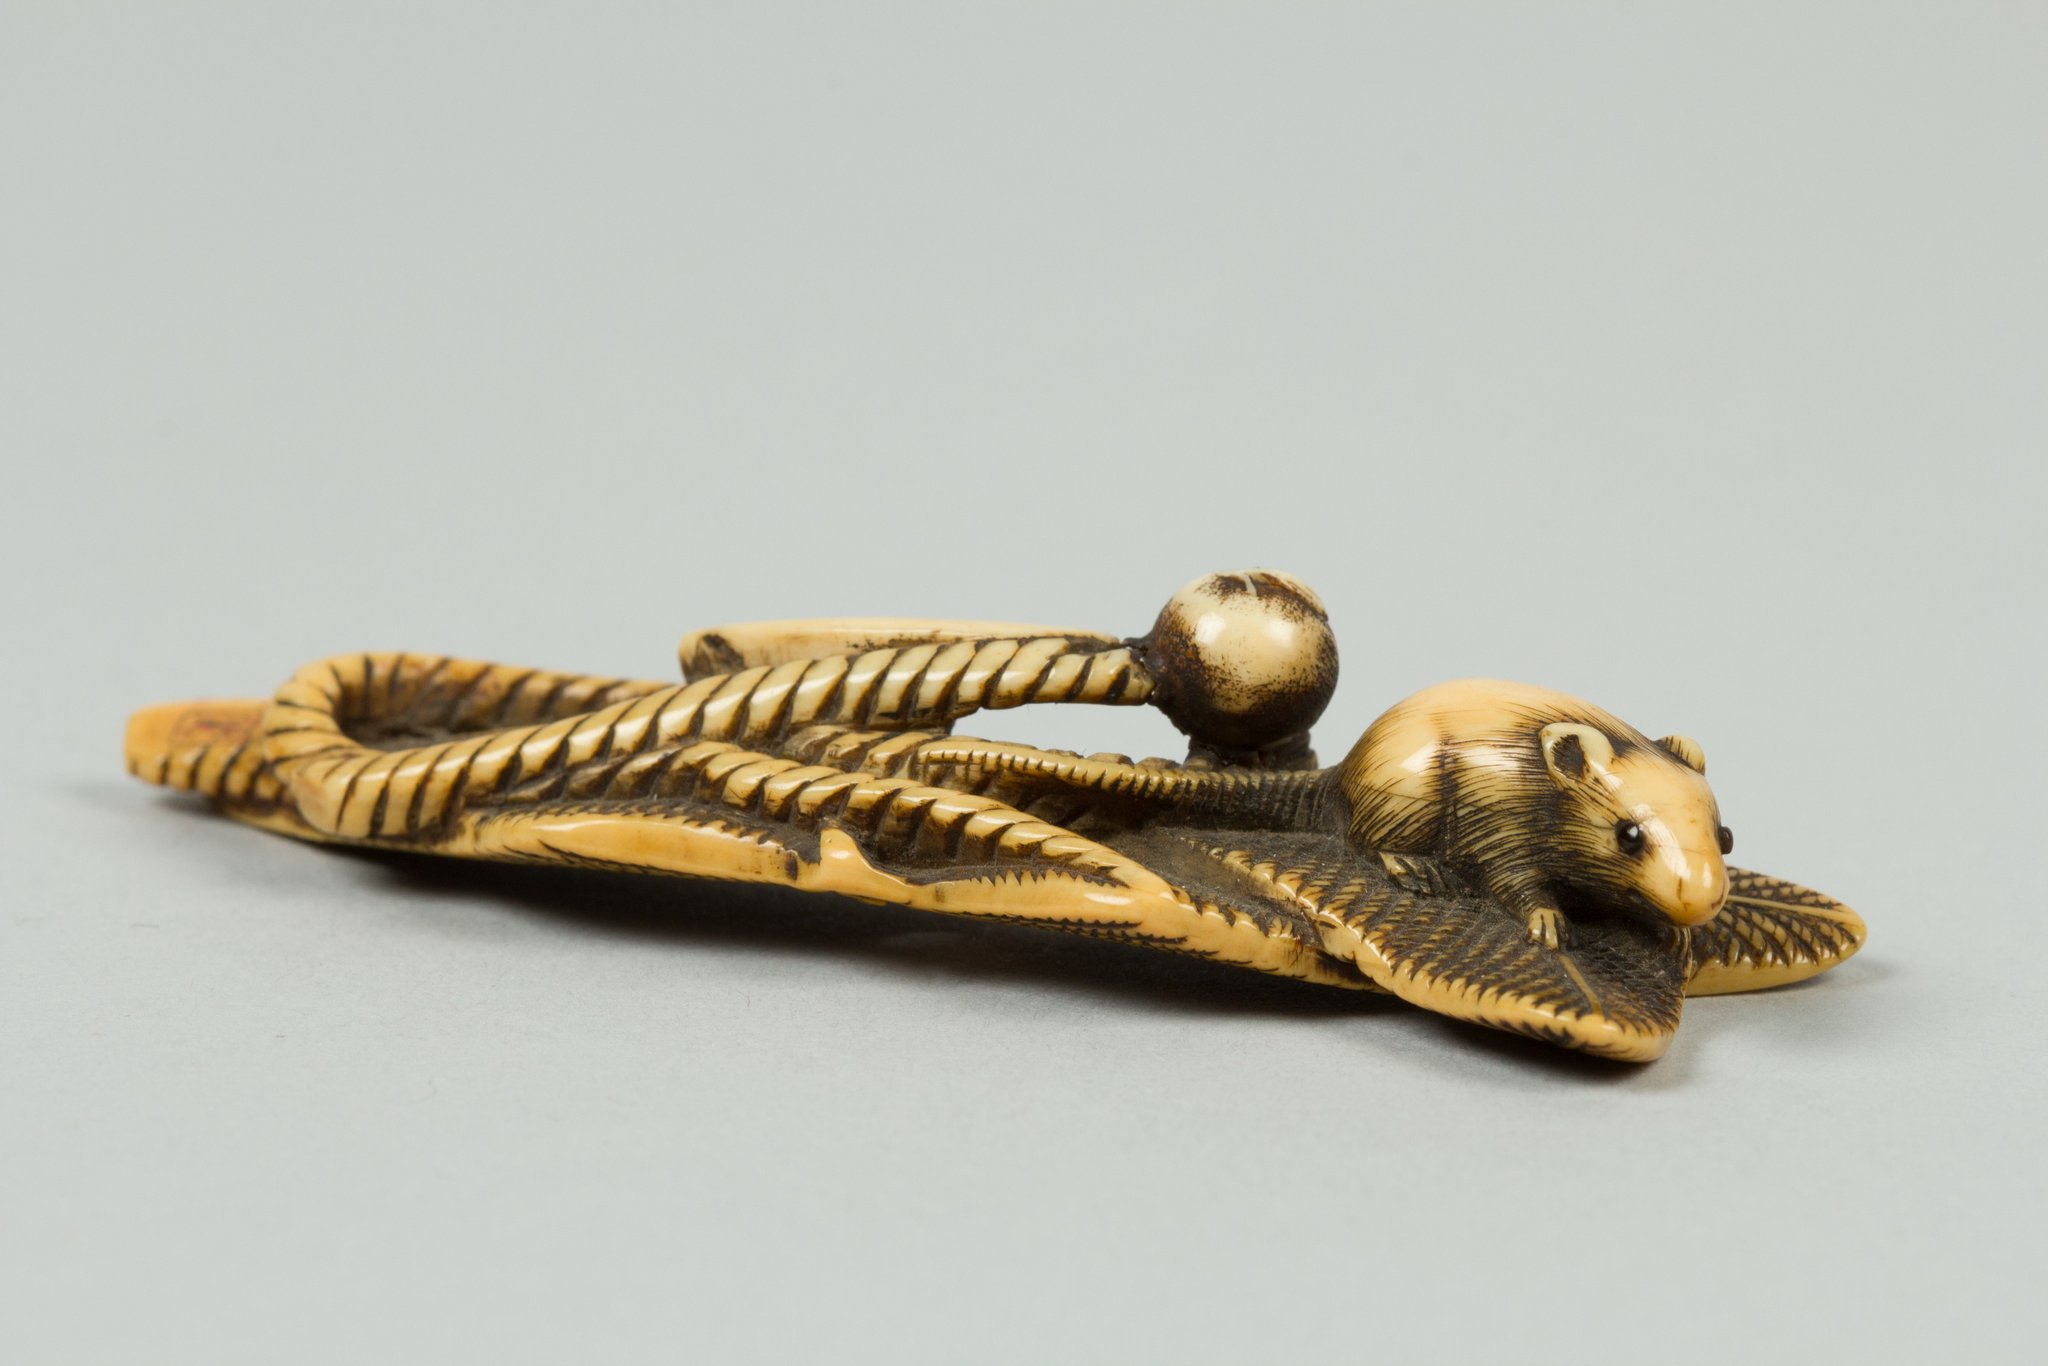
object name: netsuke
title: Netsuke of Mouse and Leaves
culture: japanese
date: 1701-1800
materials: ivory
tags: mice,leaves